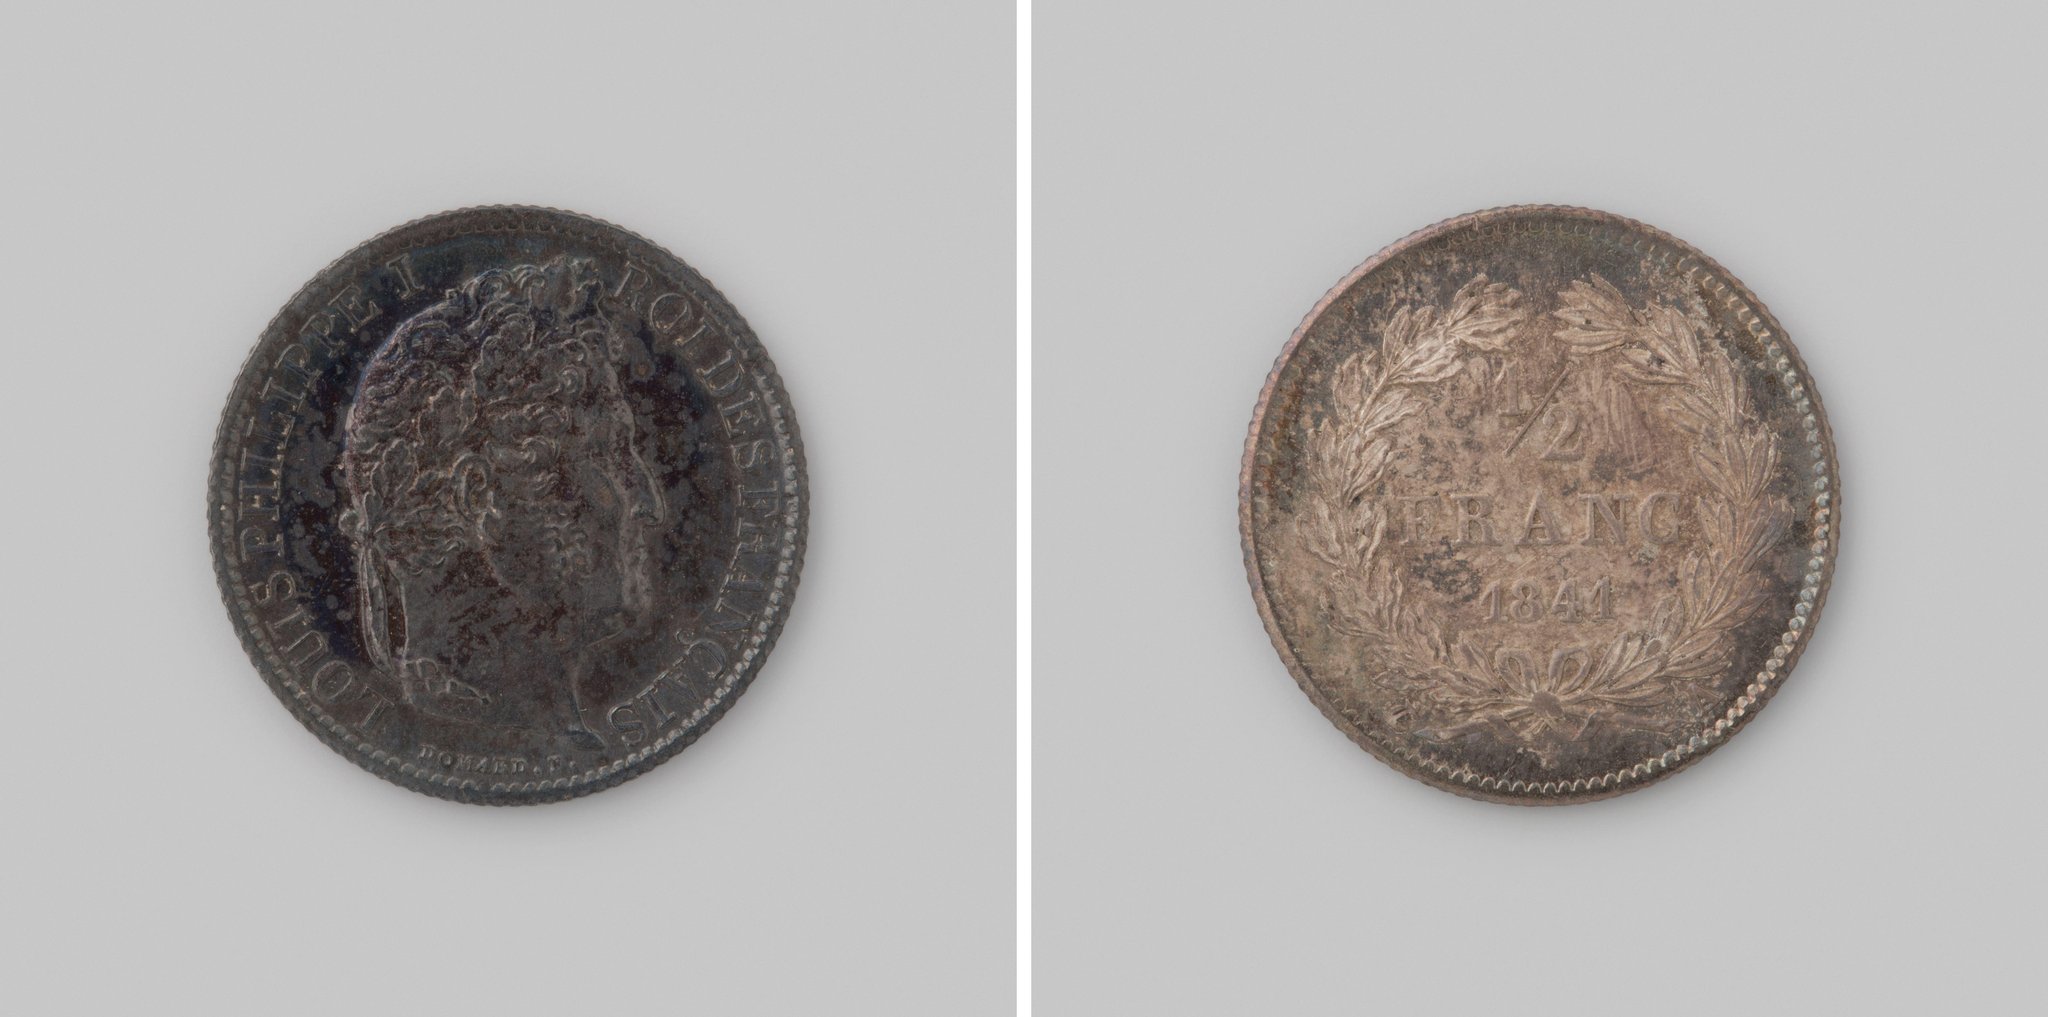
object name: coin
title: ½ franc uit het koninkrijk Frankrijk van Louis Philippe I, 1841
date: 1841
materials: silver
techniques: striking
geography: paris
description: Zilveren munt. Voorzijde: hoofd van de koning met krans van eikenbladeren naar rechts. Keerzijde: binnen twee samengebonden lauriertakken waarde-aanduiding in twee regels, waaronder jaartal. Onderaan rechts letter A [=Parijs]. Kartelrand.